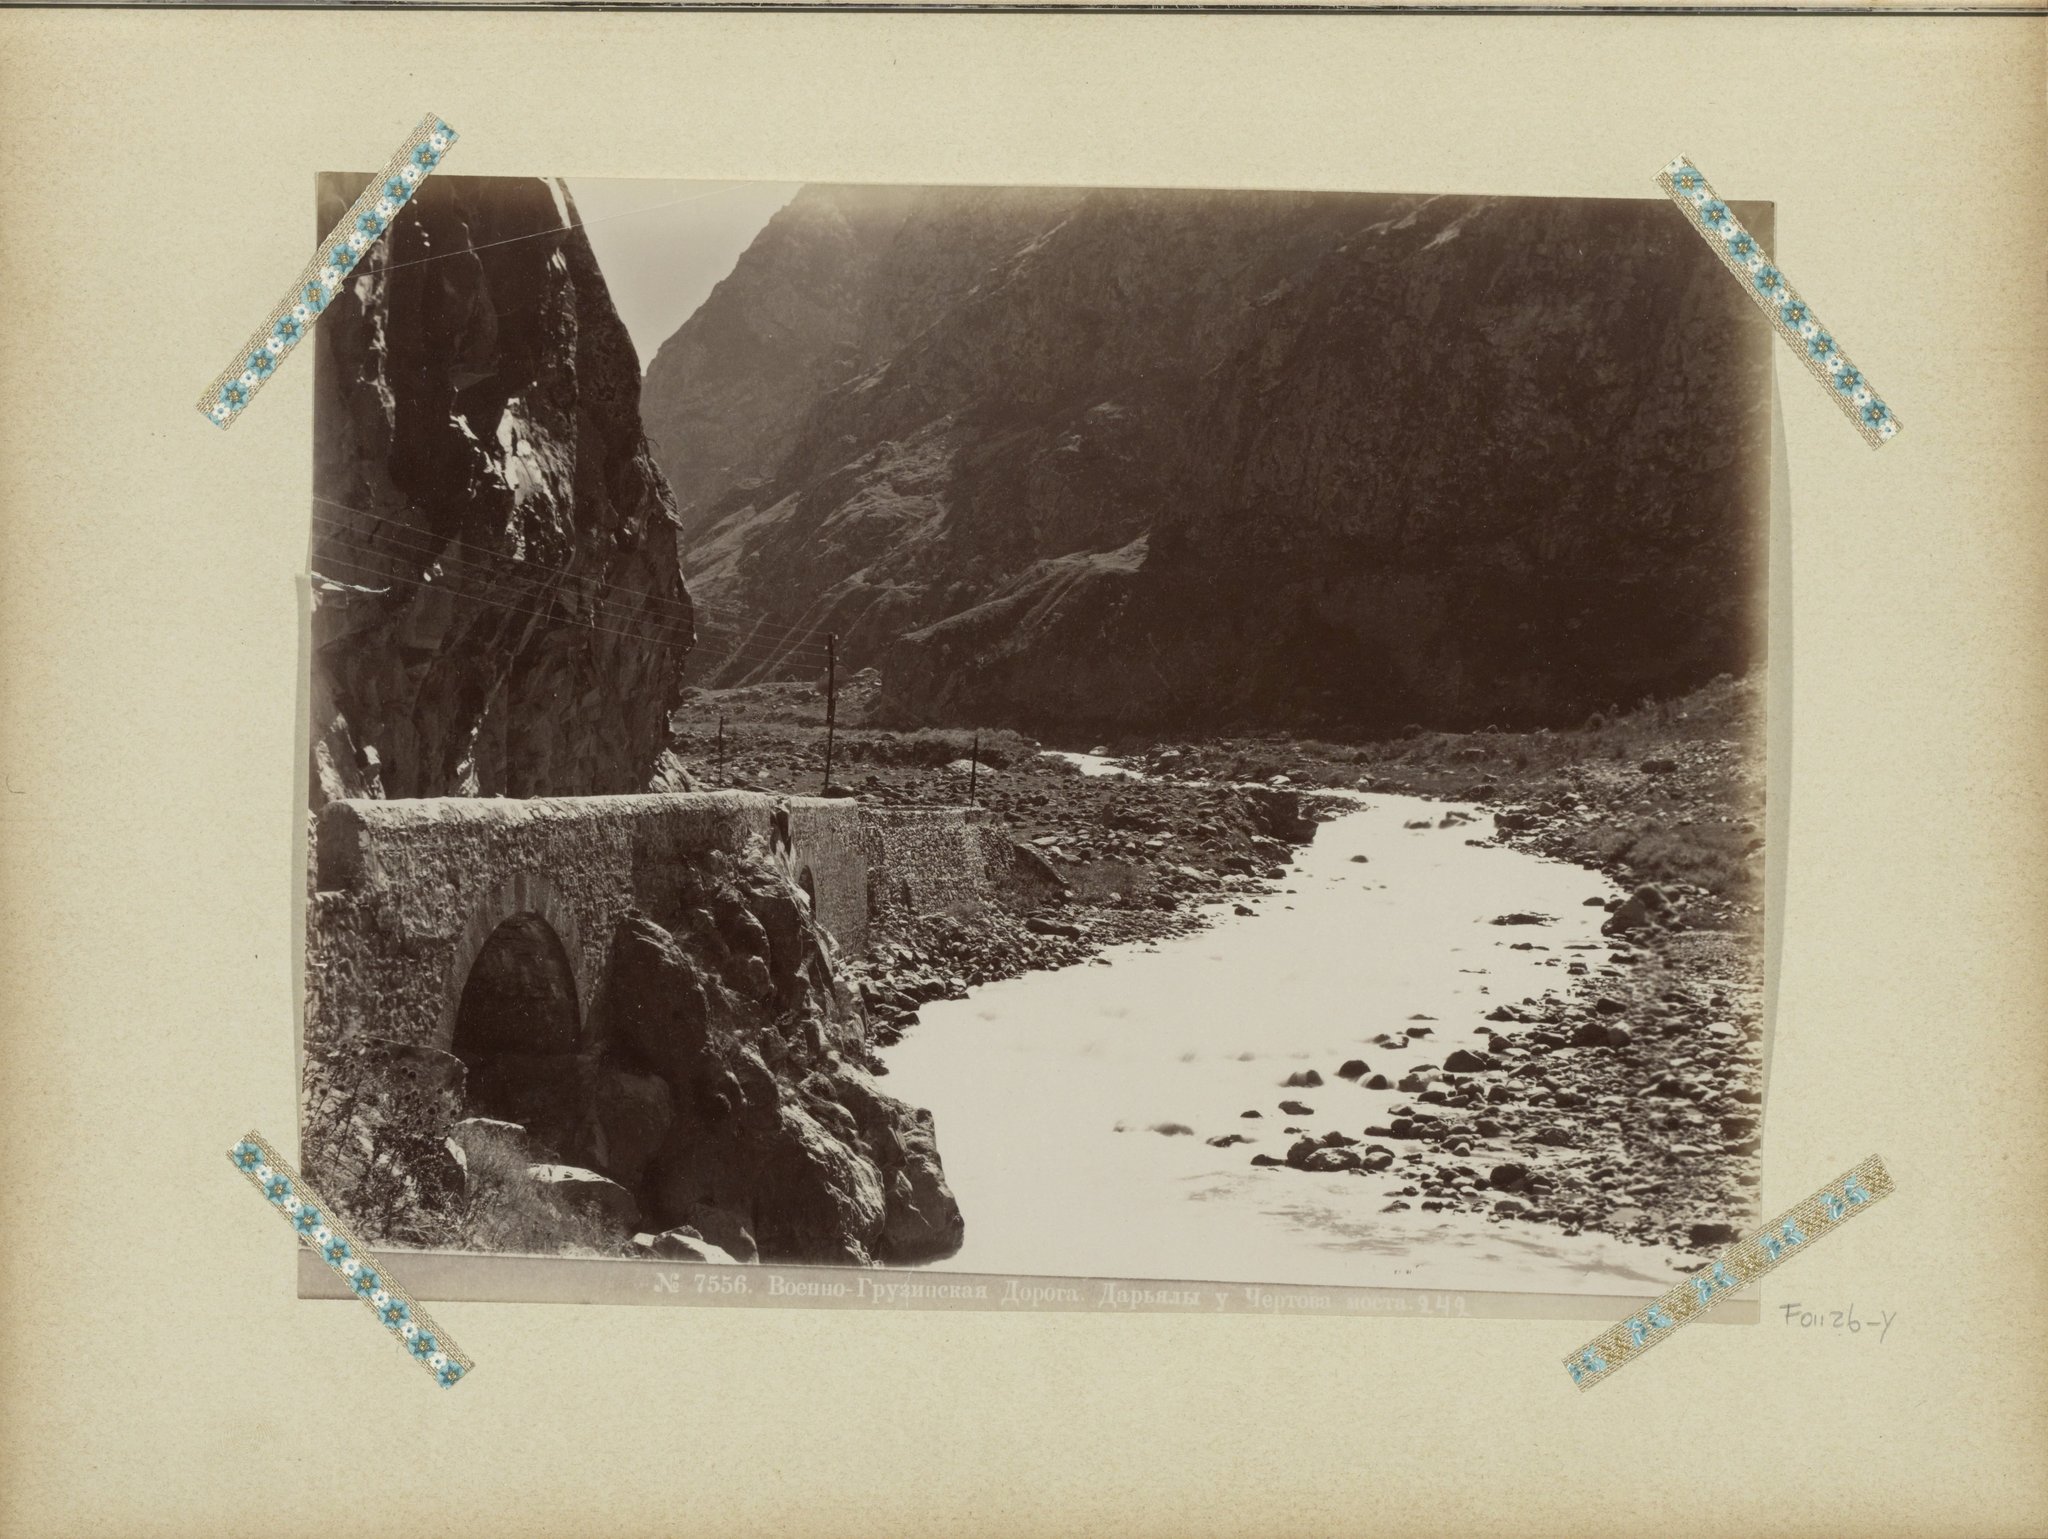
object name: photograph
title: Woenno-Groezinskaja doroga. Darjal oe Tsjortowa Mosta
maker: dimitri ivanovitch ermakov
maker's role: fotograaf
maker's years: 1845-1916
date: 1890-1900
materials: photographic support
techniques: albumen print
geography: georgia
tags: river, landscape with bridge, viaduct or aqueduct, road, path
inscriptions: number: ‘242’, number: ‘7556’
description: Onderdeel van Fotoalbum met opnames van bezienswaardigheden in Georgië, Sint-Petersburg en Moskou.